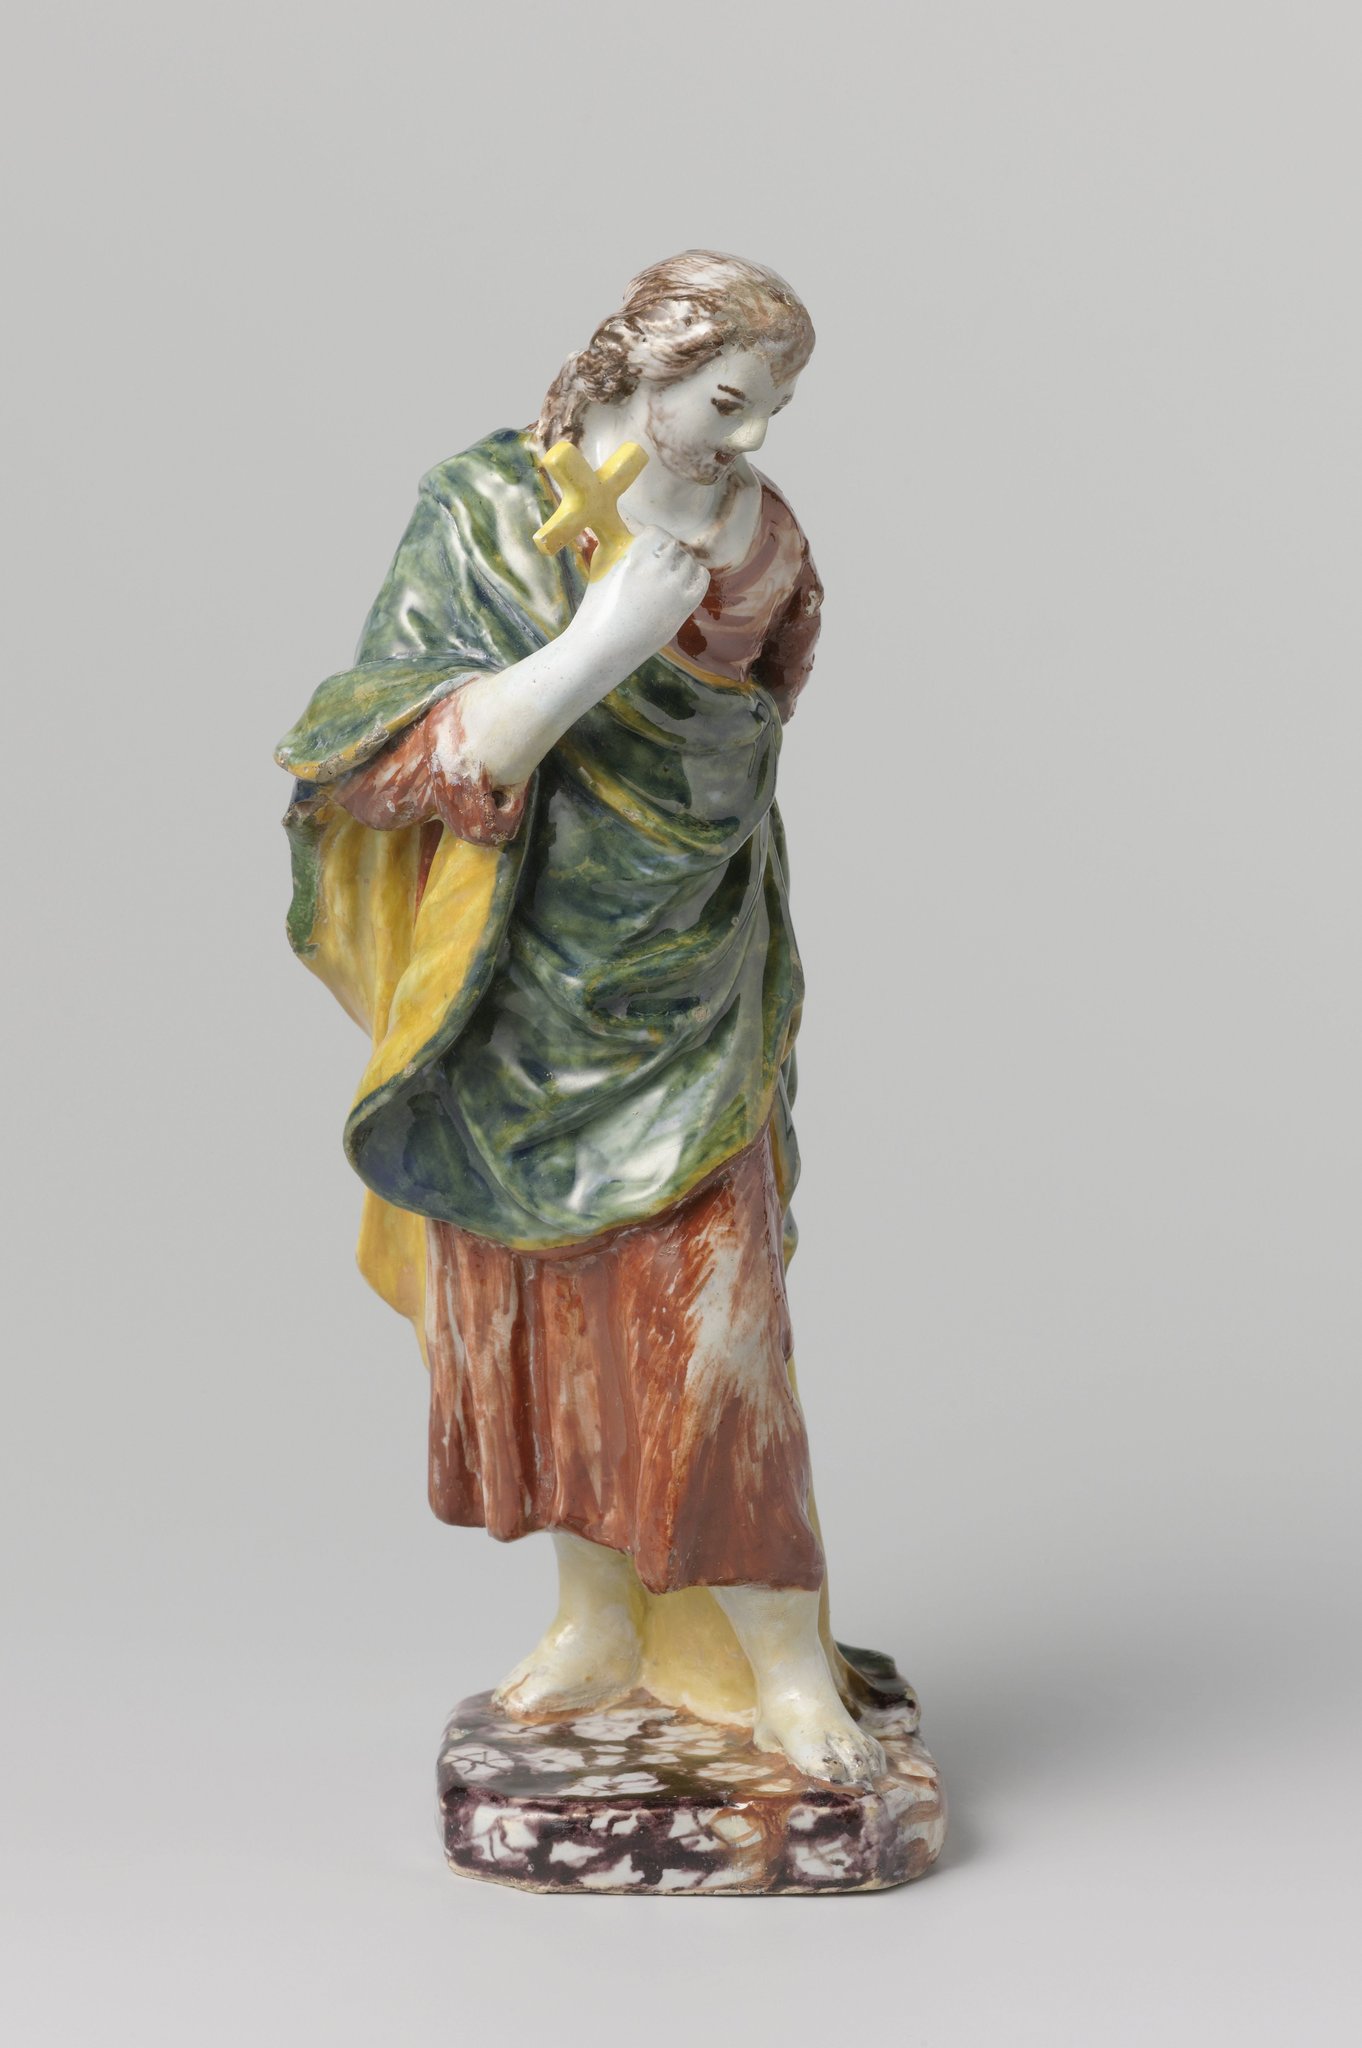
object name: mannenfiguur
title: Mannenfiguur van faience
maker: Anonymous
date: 1760-1785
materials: faience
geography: delft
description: Mannenfiguur van faience, voorstellende een apostel met een kruis in de hand. Veelkleurig beschilderd.